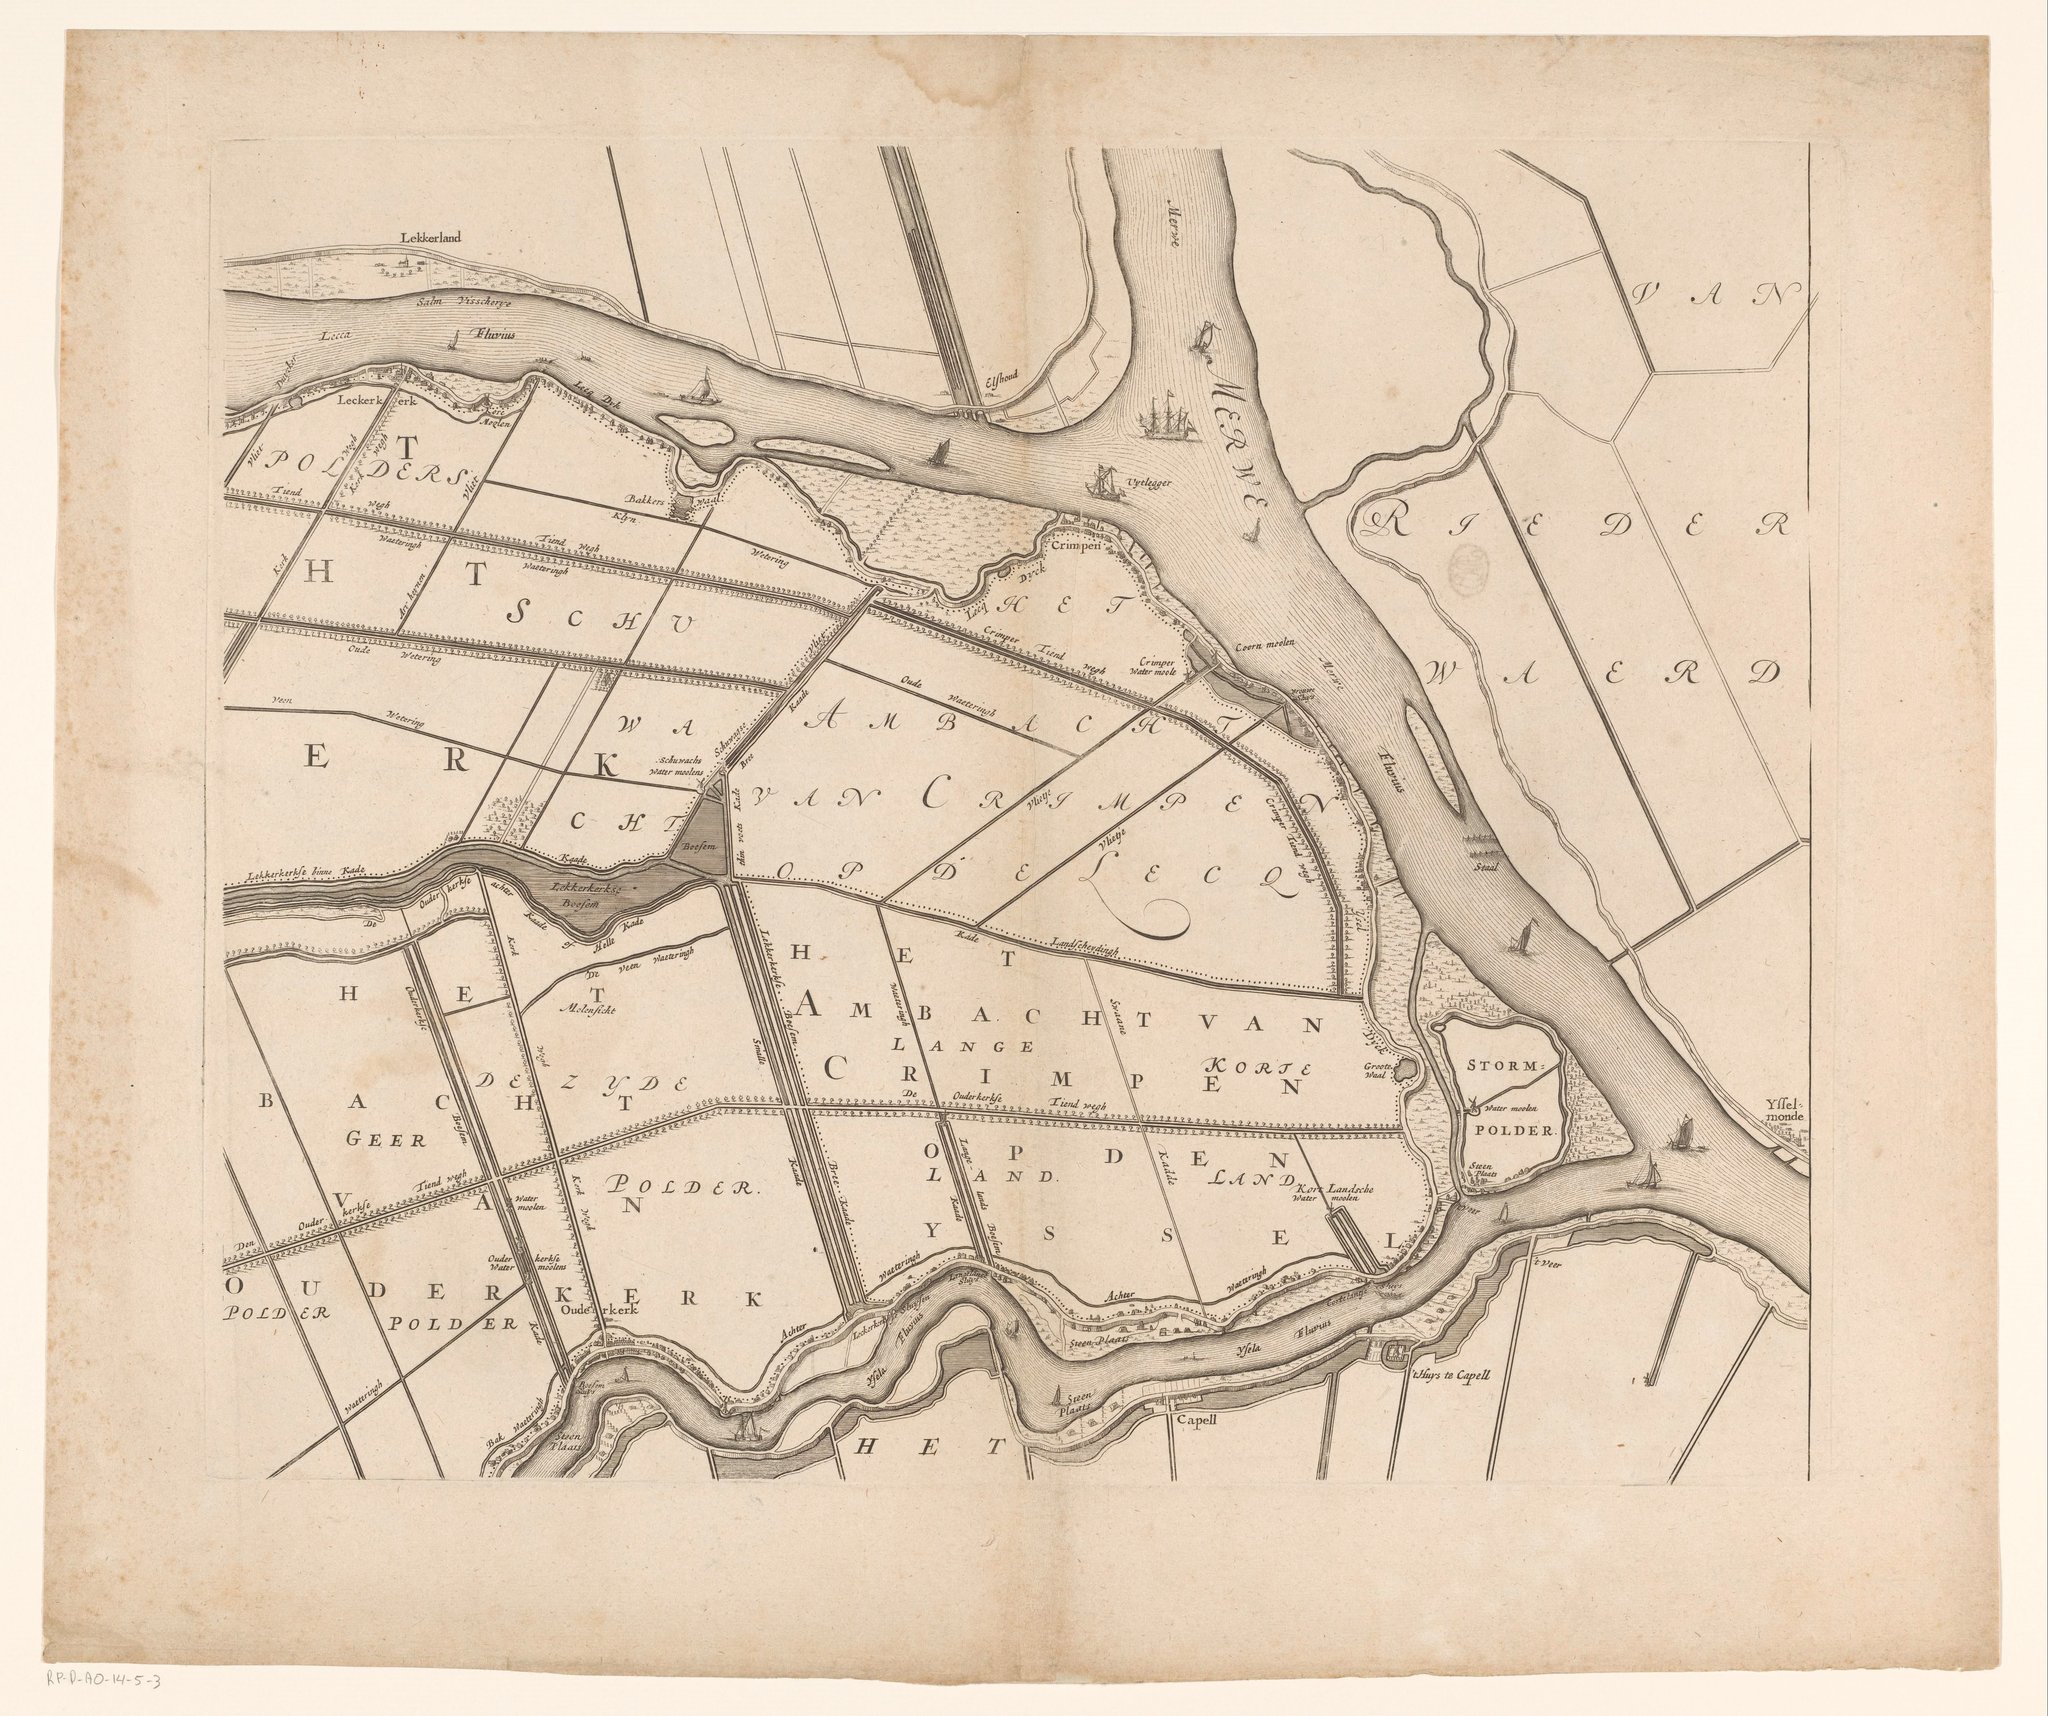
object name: print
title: Kaart van het Hoogheemraadschap van de Krimpenerwaard (derde deel van kaart)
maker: johannes leupenius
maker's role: draughtsman, painter, print maker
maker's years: 1646-1693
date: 1683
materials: paper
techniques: engraving, etching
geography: amsterdam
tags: maps of separate countries or regions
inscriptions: collector's mark: Lugt 195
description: Derde deel van de kaart van de derde druk van 'Het Hooge Heemraadschap vande Crimpenre Waard', een wandkaart (bestaande uit een zesdelige kaart en een wapenrand) van het Hoogheemraadschap van de Krimpenerwaard.